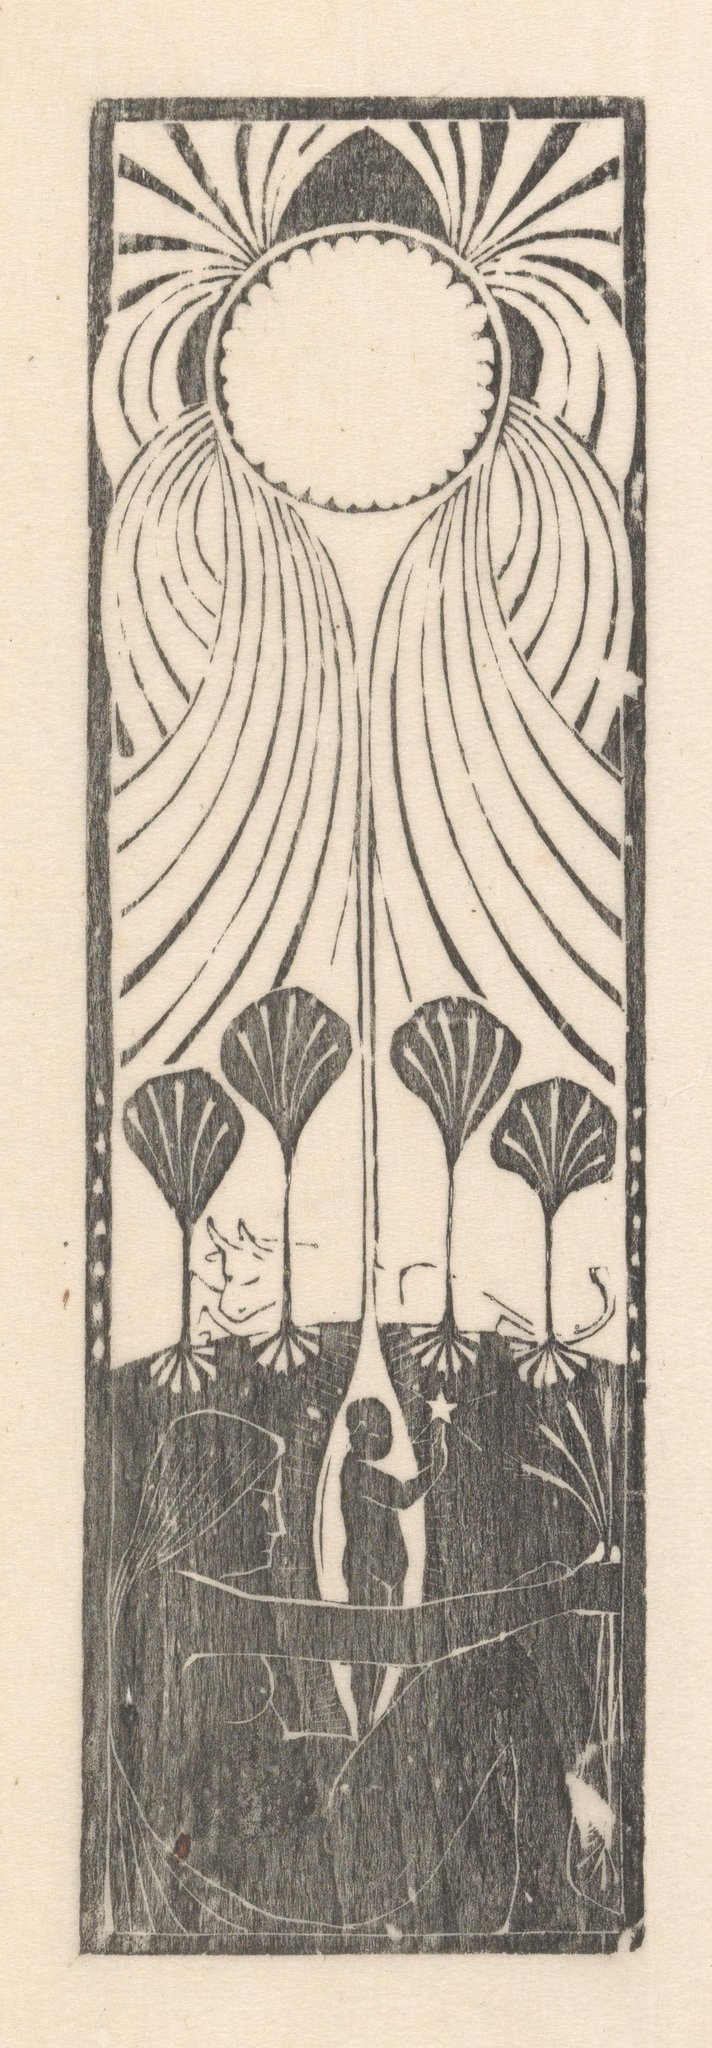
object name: print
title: Vrouw, man en rund in veld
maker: karel petrus cornelis de bazel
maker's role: draughtsman, print maker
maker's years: 1869-1923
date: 1894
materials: paper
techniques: woodcut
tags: trees, (showing oneself) undressed, quasi-nude, sunbeams, bovine cattle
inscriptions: collector's mark: Lugt 2228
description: Een zittende, naakte vrouw houdt enkele korenhalmen vast. Ze bevindt zich op een veld waar een naakte man staat, een rund ligt en vier bomen groeien. Het tafereel wordt beschenen door zonnestralen.